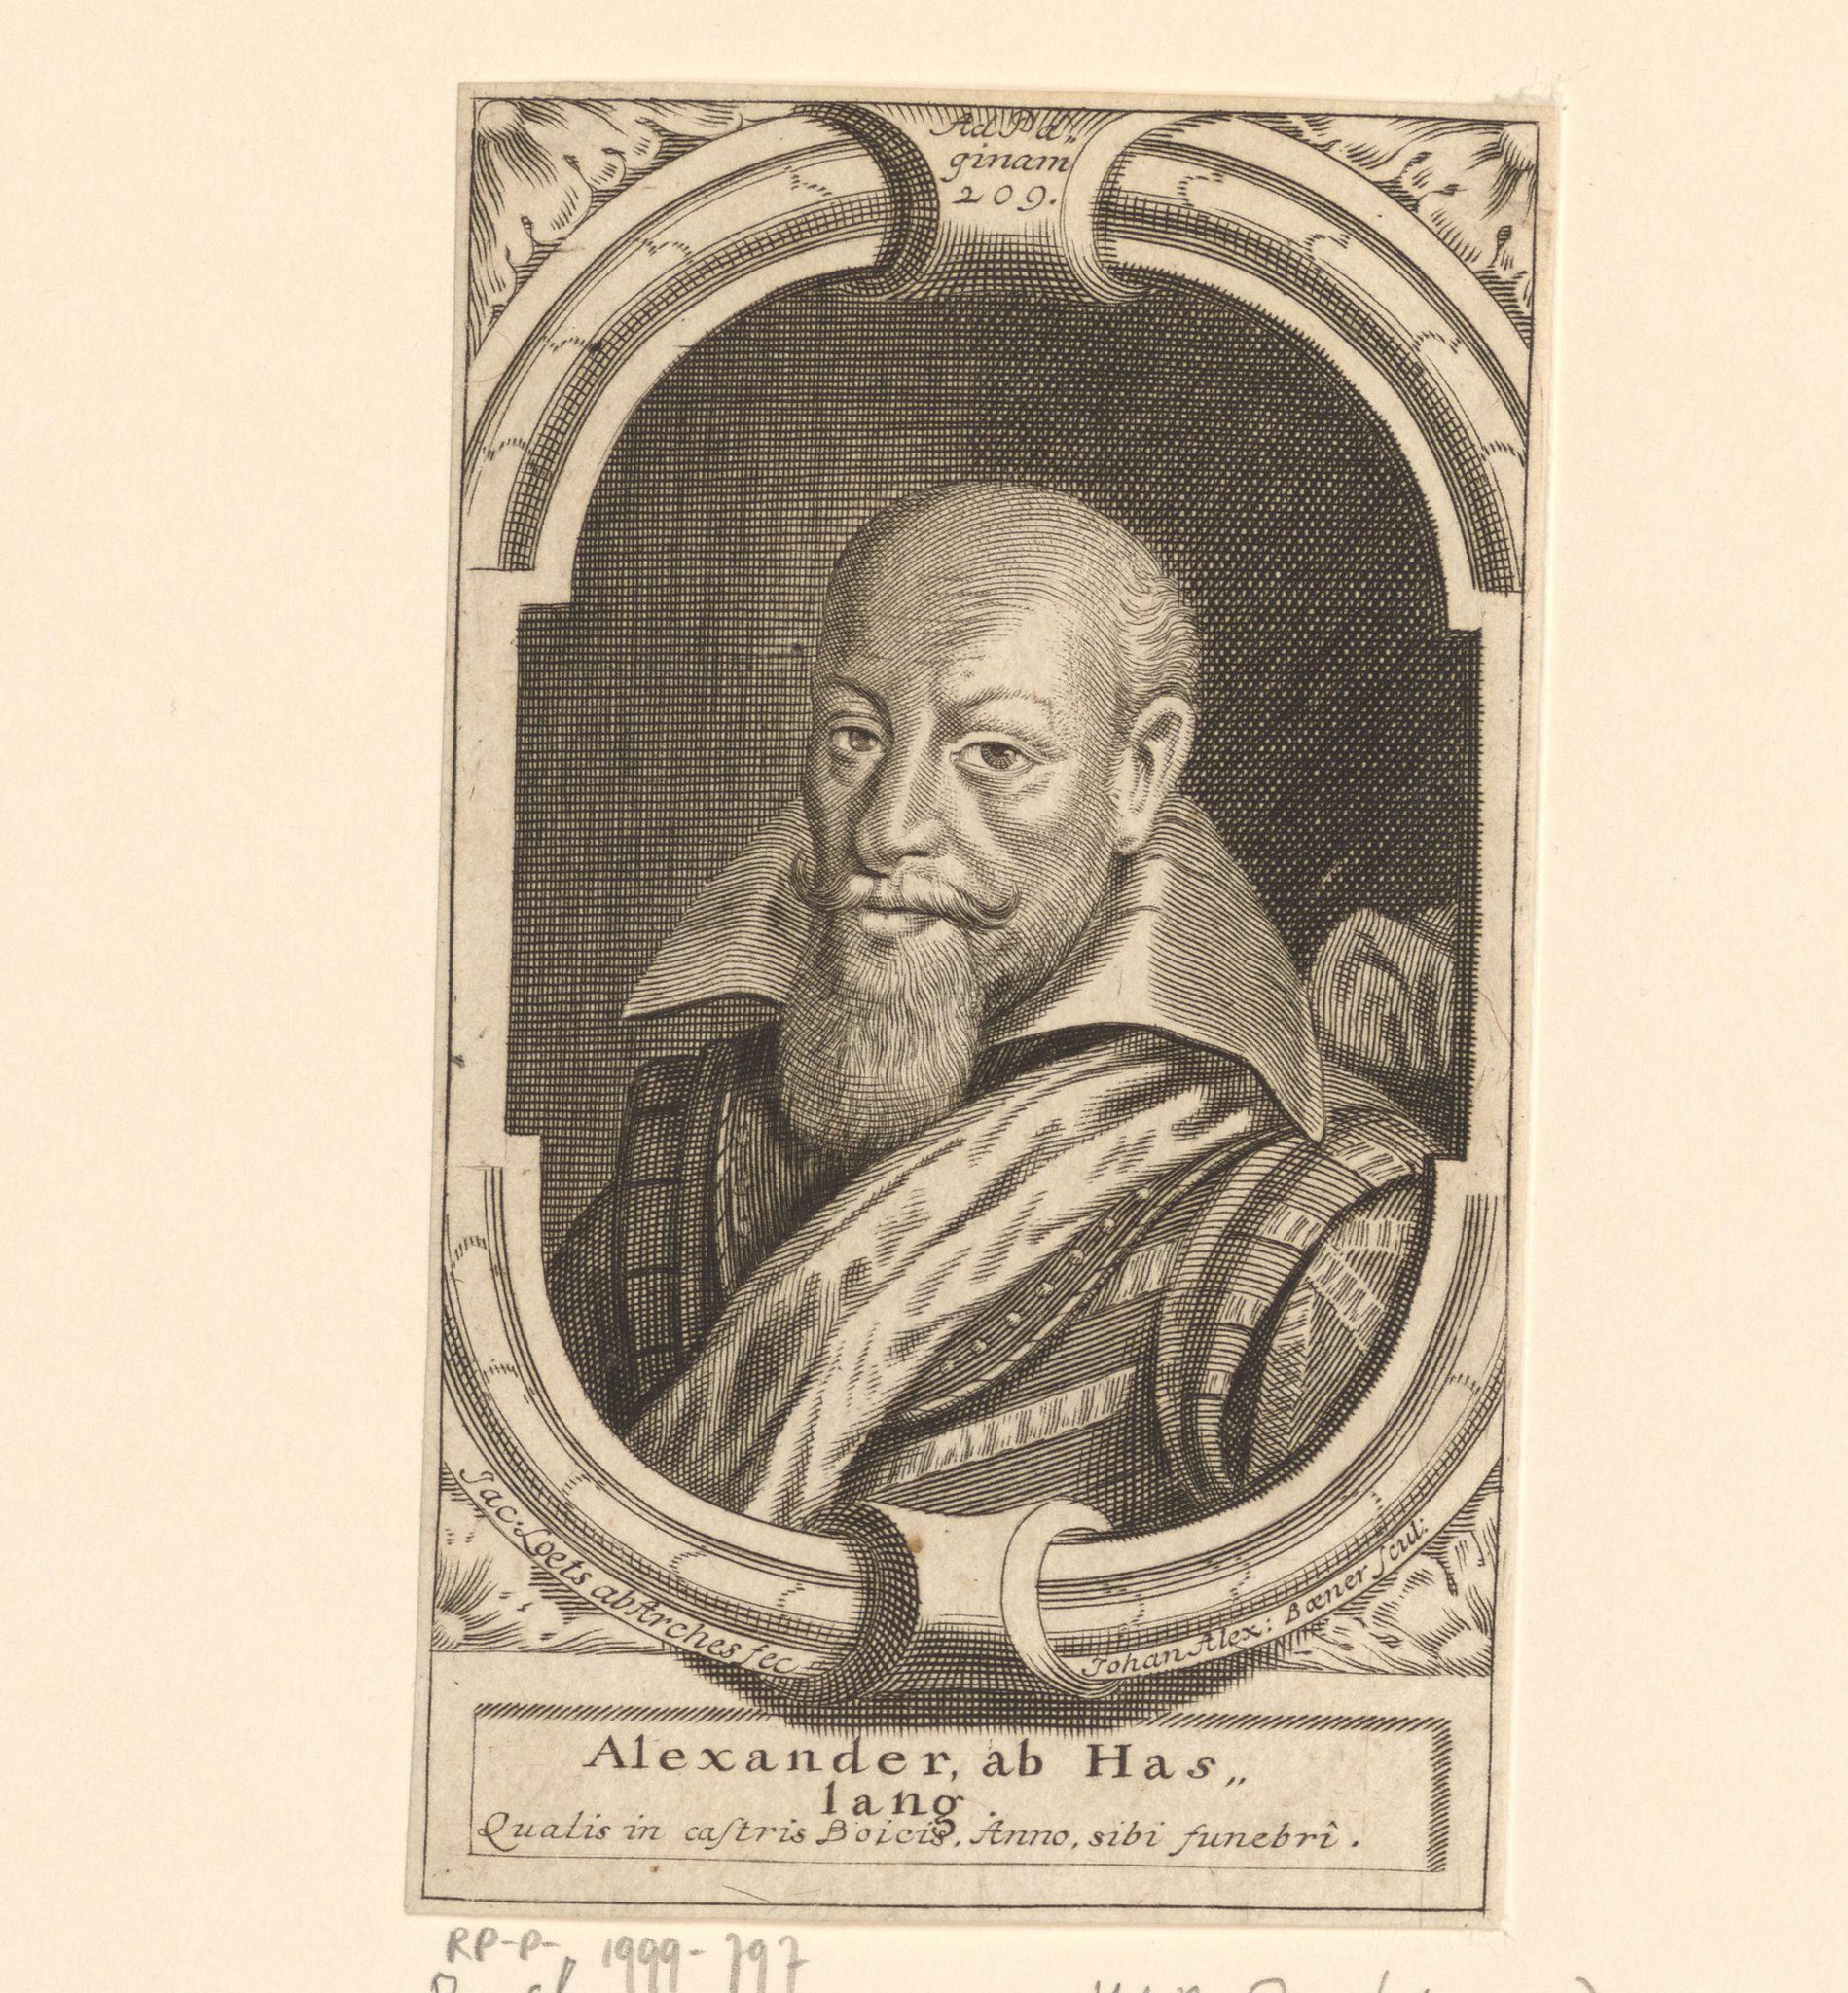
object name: print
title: Portret van Alexander von Hasslang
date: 1677-1727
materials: paper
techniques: engraving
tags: historical persons, commander-in-chief, admiral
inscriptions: collector's mark: Lugt 2228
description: Prent voor het eerst gebruikt in: Bissel, Johannes. Leo Galeatus, anni MDCXX. Amberg: Johannes Burger, 1677. Ook gebruikt in latere edities van bijvoorbeeld 1724, 1725 en 1727.